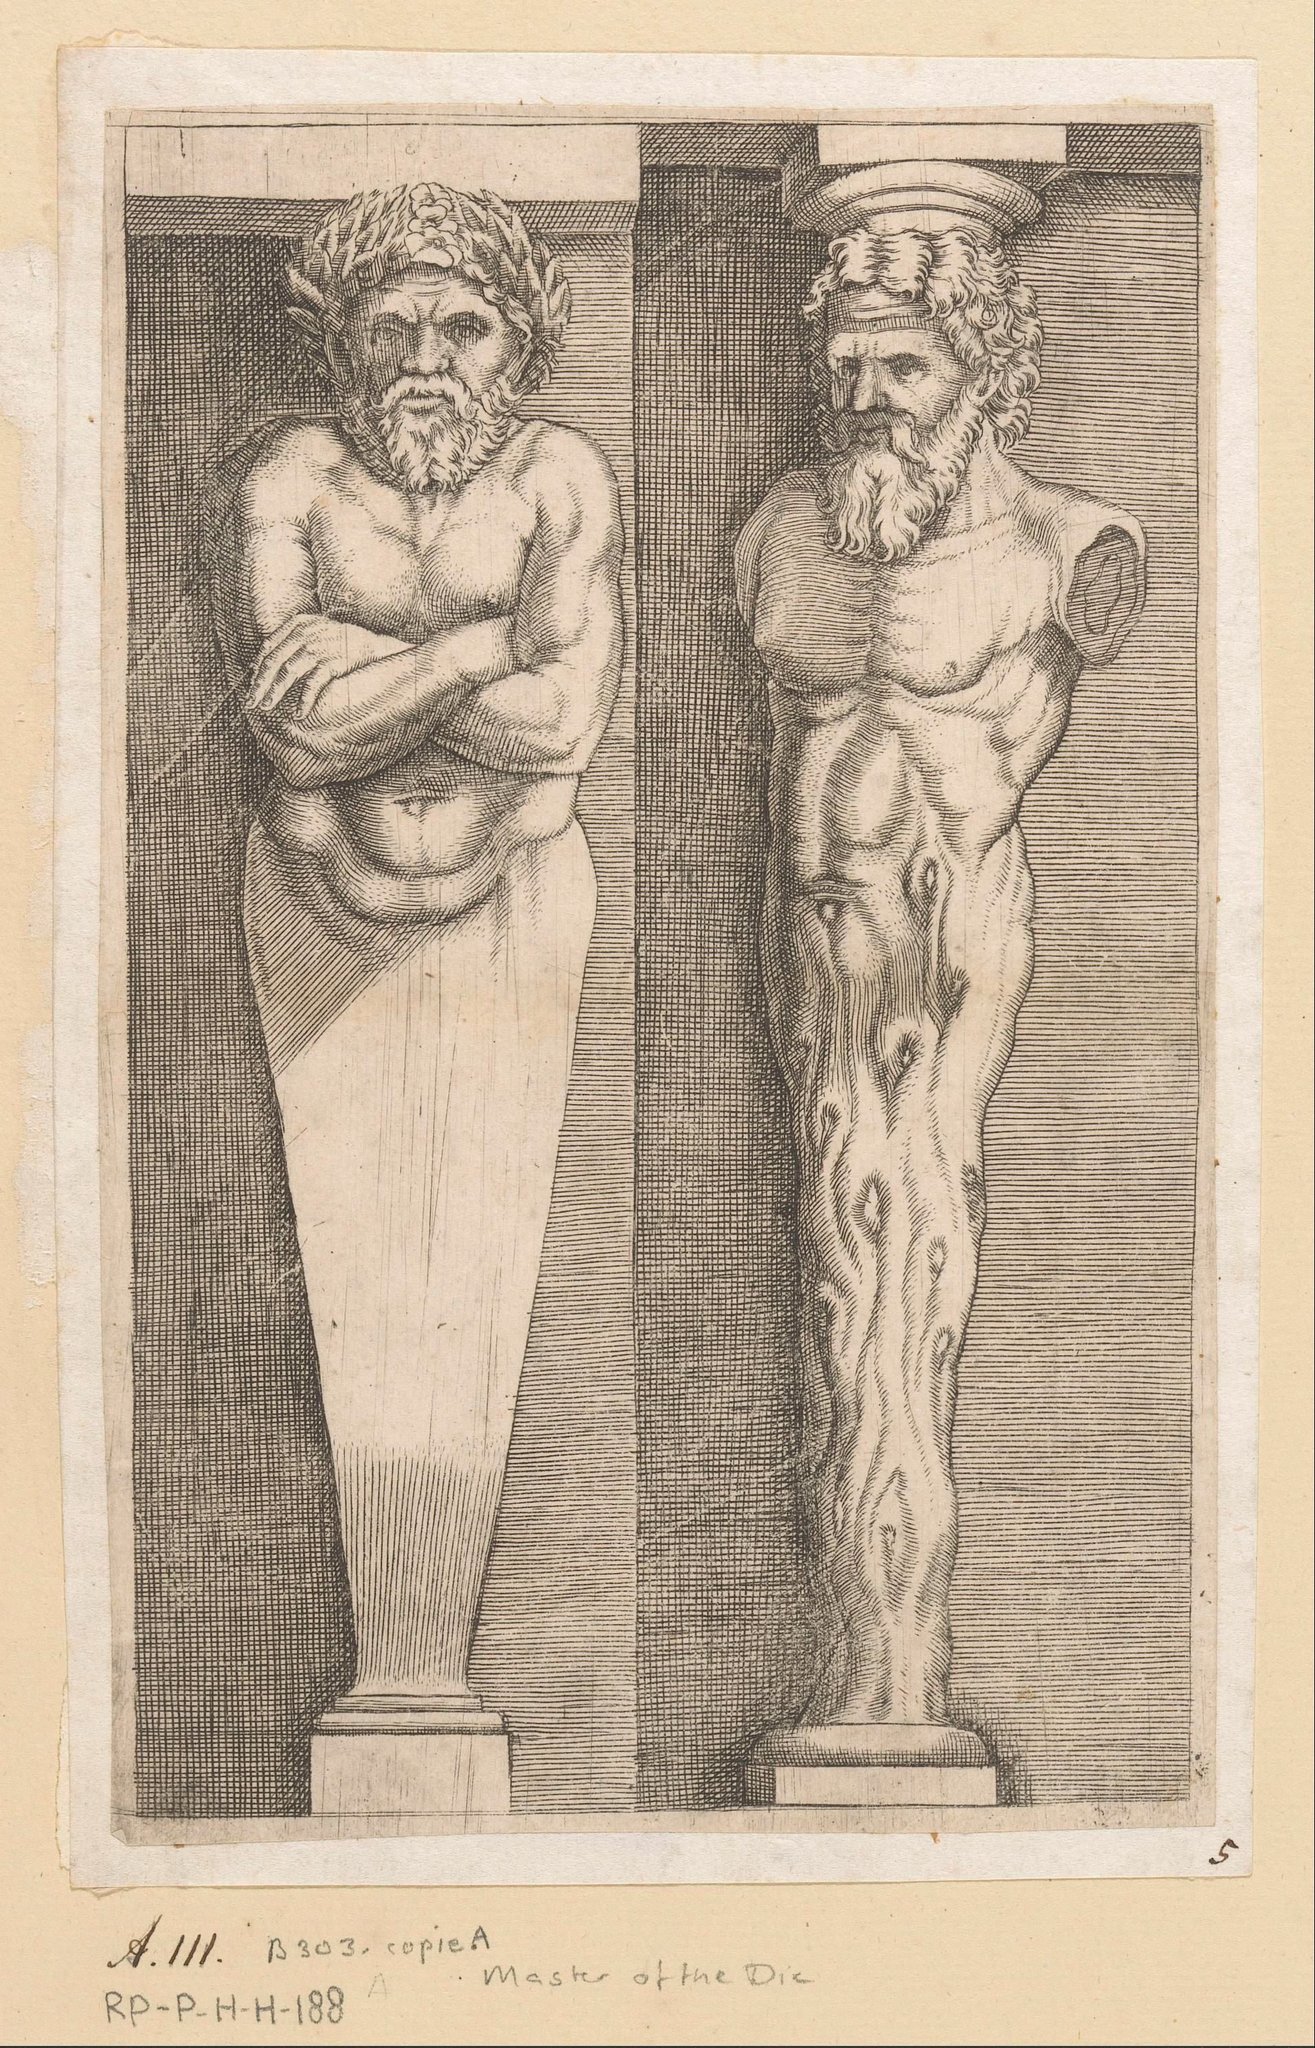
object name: print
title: Hermen (kopieën)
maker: meester van de dobbelsteen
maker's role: print maker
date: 1536-1570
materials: paper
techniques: engraving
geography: italy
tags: constructive (architectural) parts ~ human beings, trees (+ stem, trunk)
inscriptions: collector's mark: ‘Hinloopen’, number: ‘5’, collector's mark: Lugt 11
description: Twee hermen (vierkante pijler met menselijke buste of bovenlichaam) van bebaarde mannen. De linker heeft het bovenlichaam van een man, een lauwerkrans op zijn hoofd en zijn armen over elkaar geslagen. De rechter heeft aan de bovenzijde een man, driekwart naar links, en aan de onderzijde een boomstam.